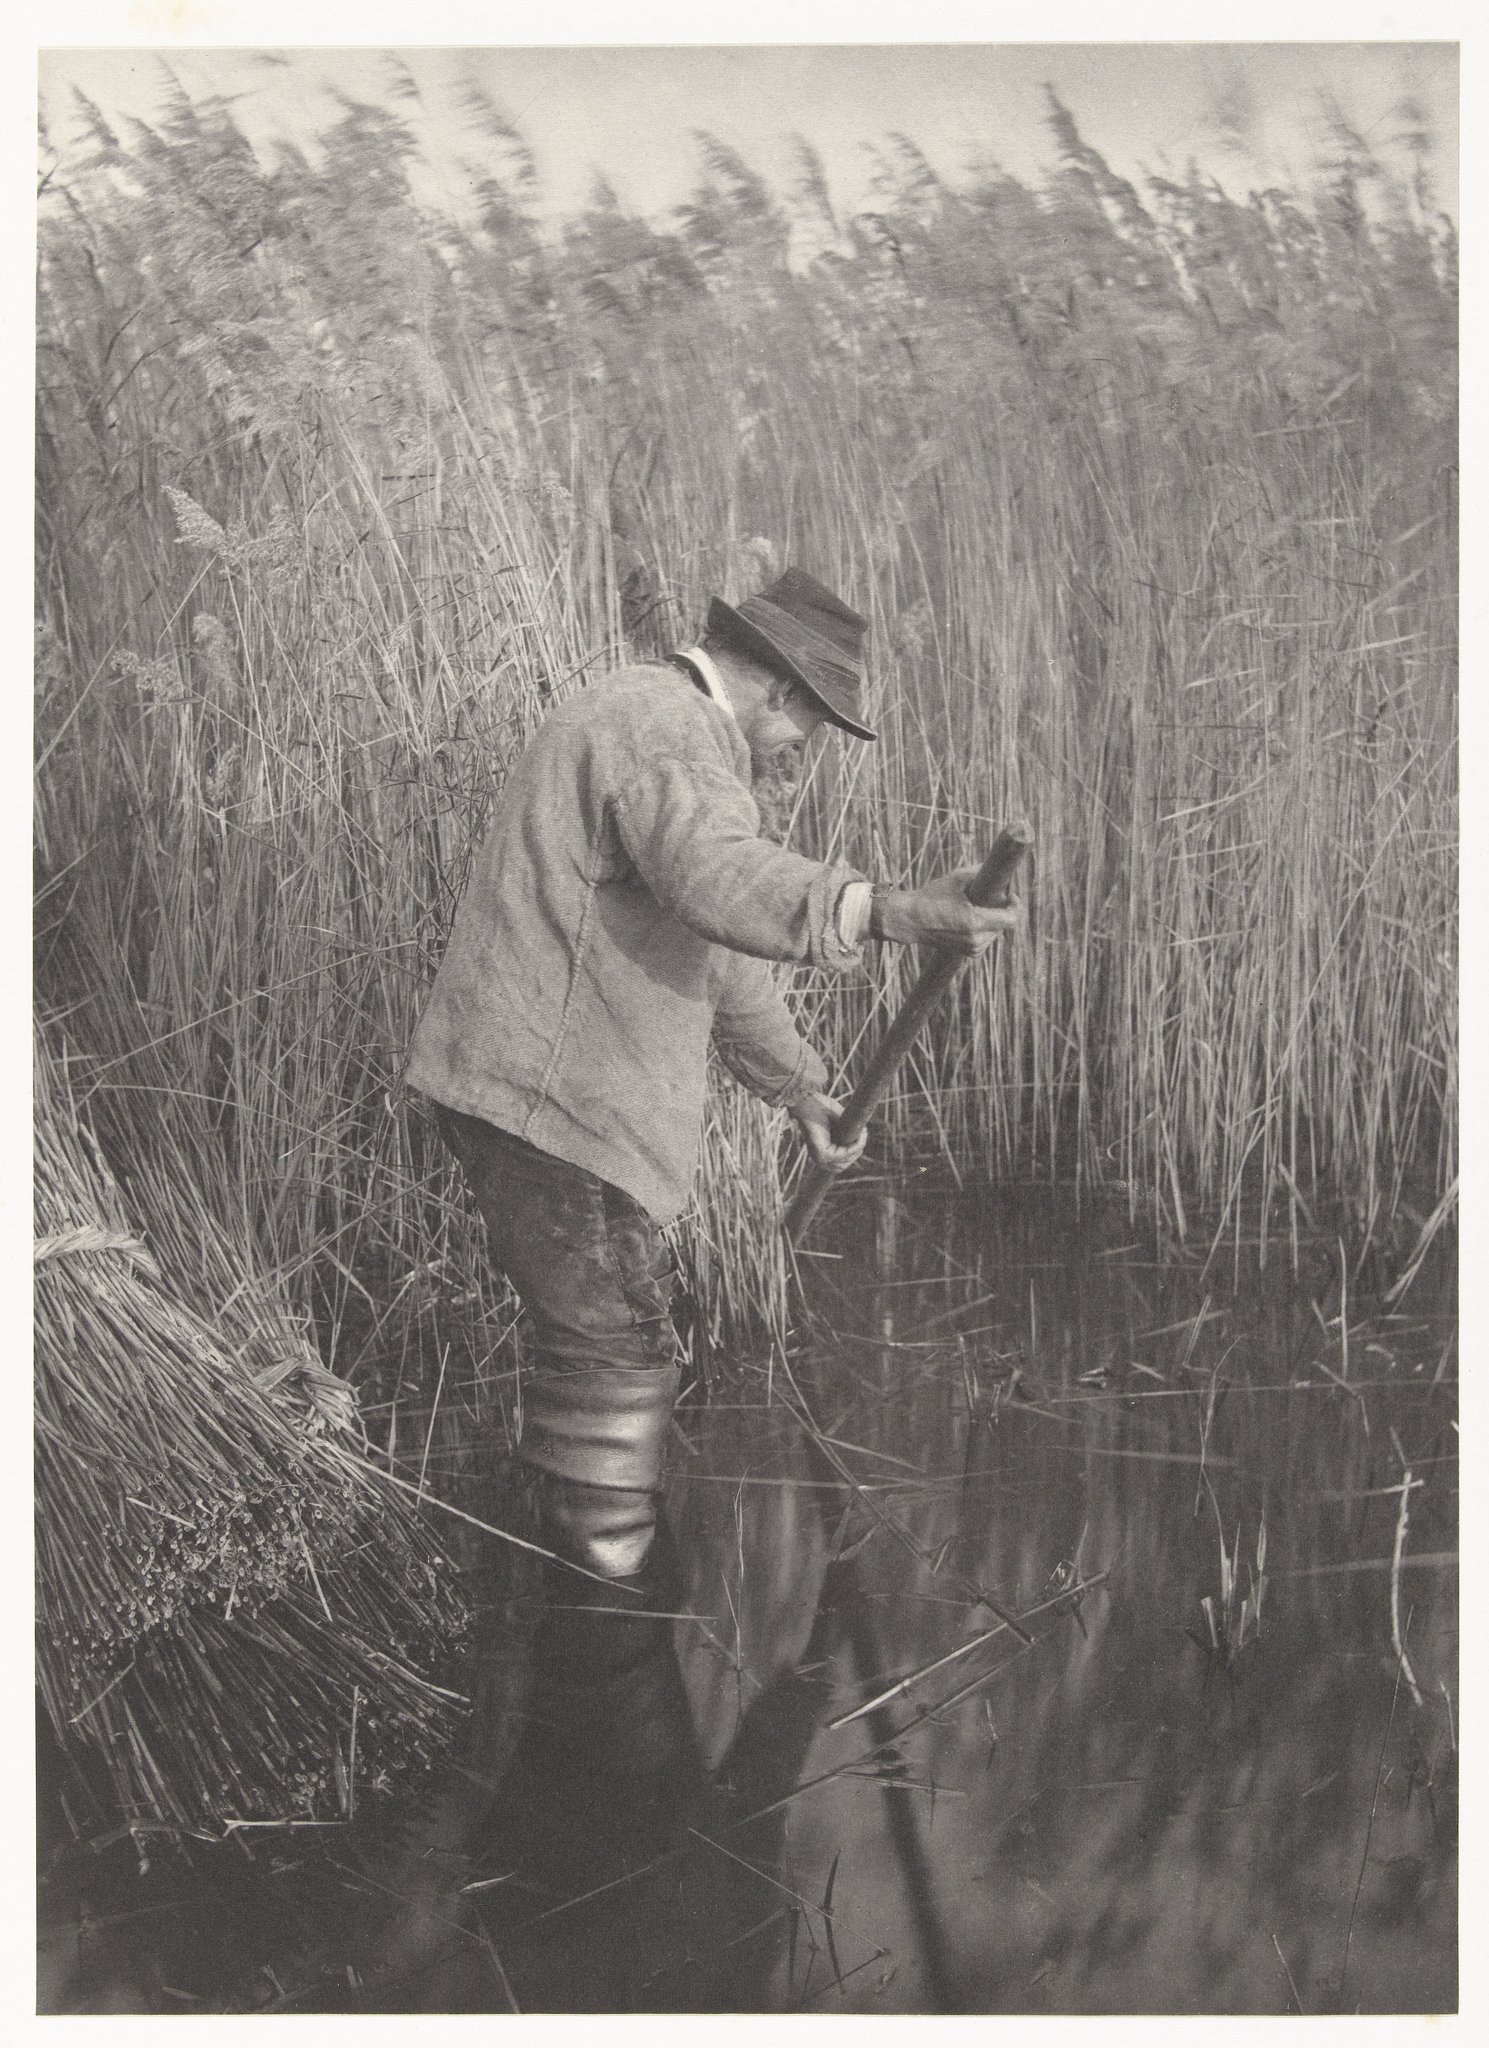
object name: photograph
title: A Reed-Cutter at Work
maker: peter henry emerson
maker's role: fotograaf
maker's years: 1856-1936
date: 1885-1886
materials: cardboard, photographic support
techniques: platinum process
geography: norfolk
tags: plants and herbs: reed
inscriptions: number: ‘A2/ 65’